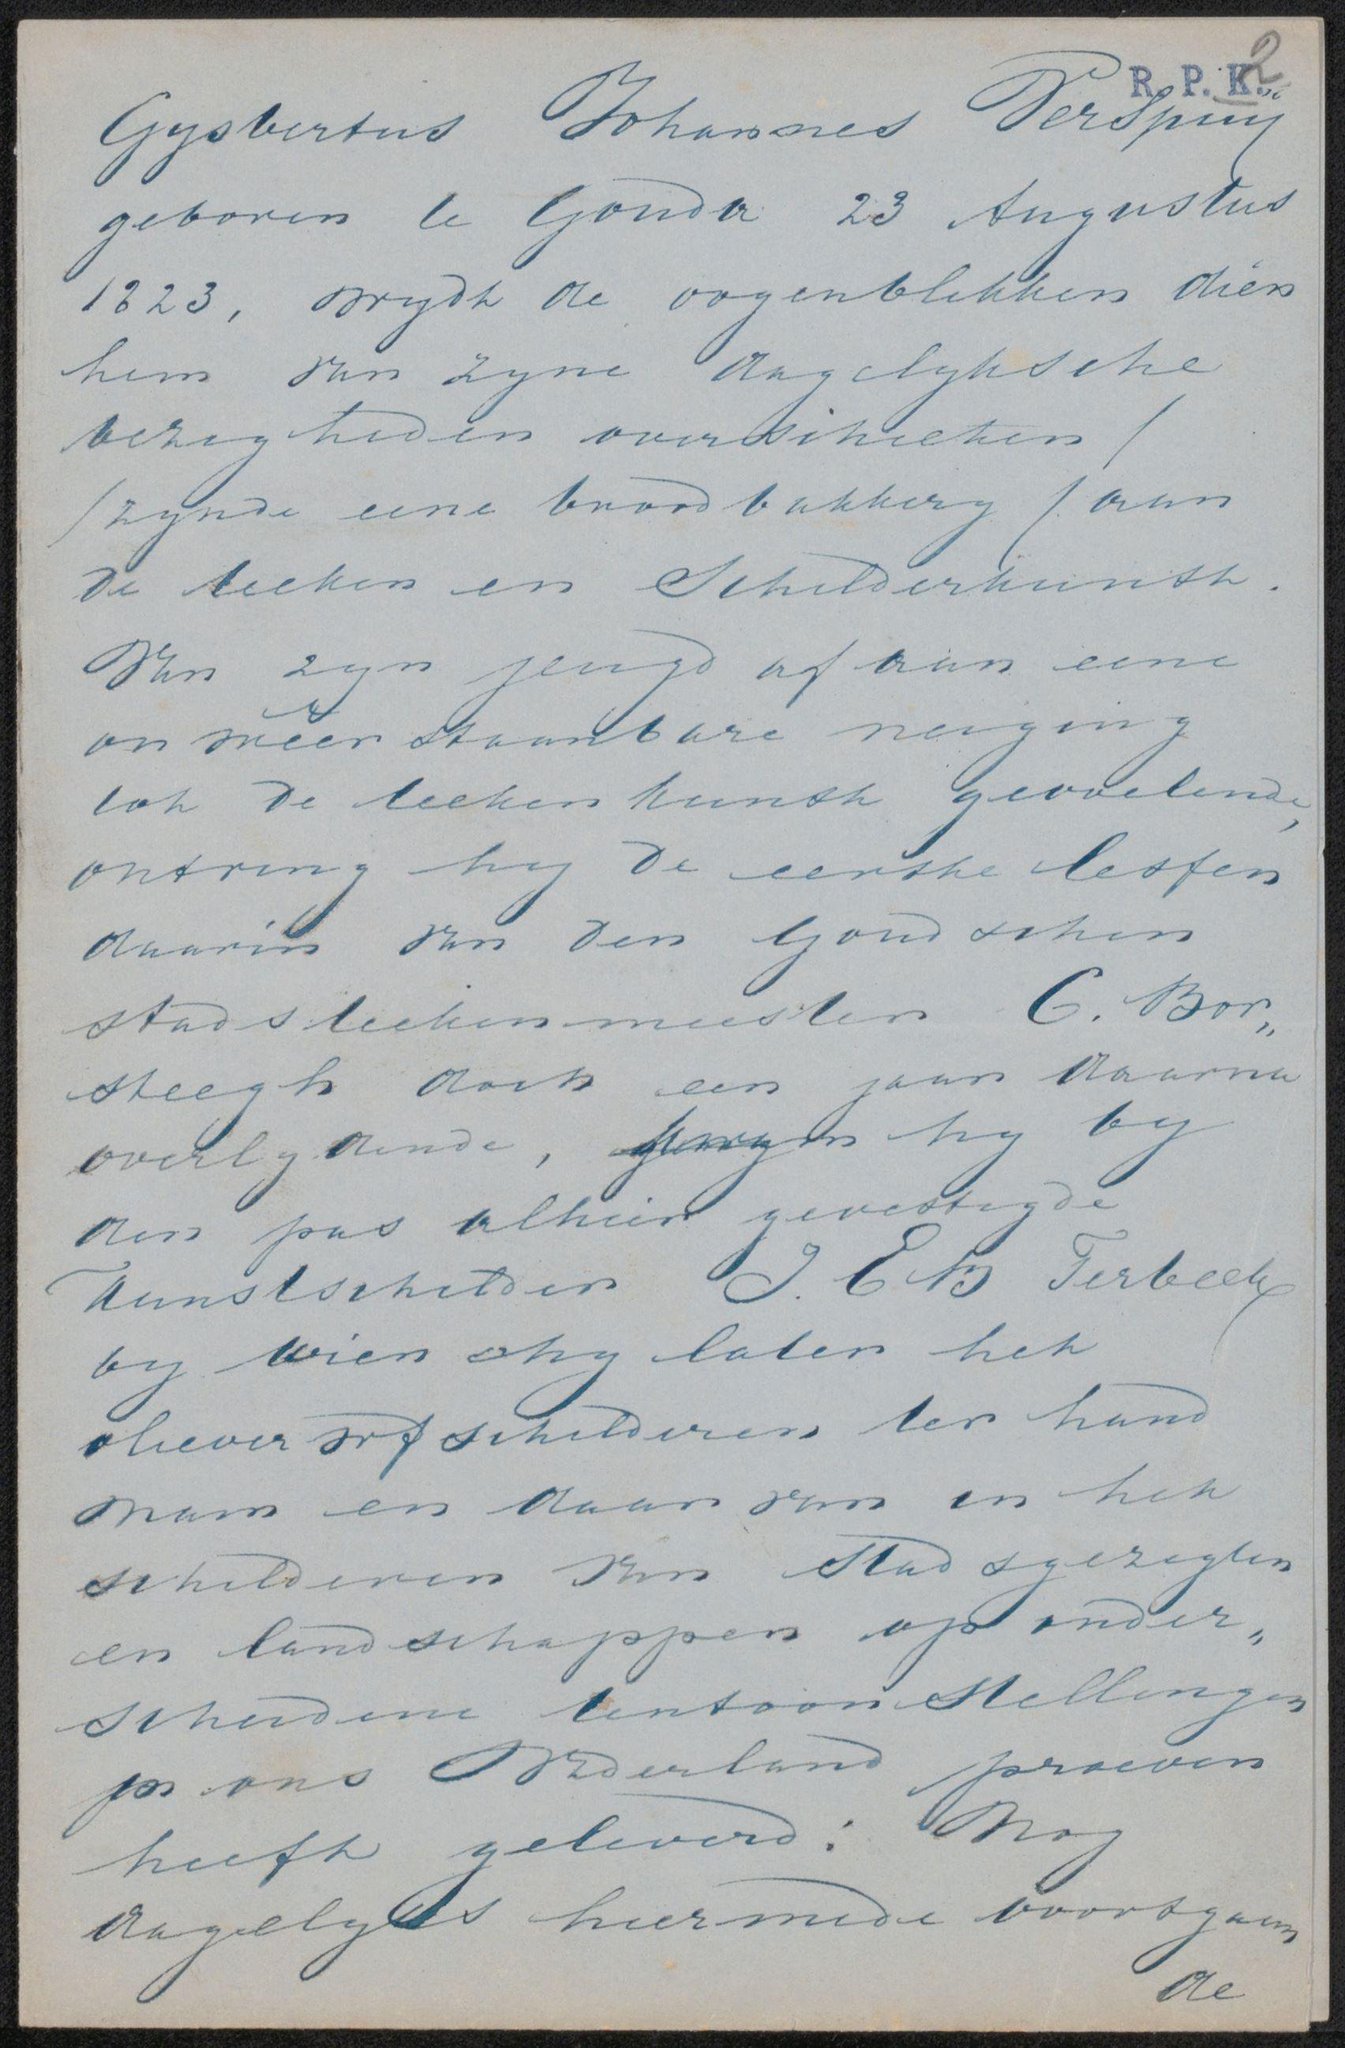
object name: letter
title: Brief aan Christiaan Kramm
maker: gijsbertus johannes verspuy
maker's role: print maker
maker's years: 1823-1862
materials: ink, paper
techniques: pen, writing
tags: cornelis borsteegh, utrecht, print maker, draughtsman, christiaan kramm, drawing, the graphic arts, exhibition ~ art, rotterdam, gouda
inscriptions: collector's mark: Lugt 2233